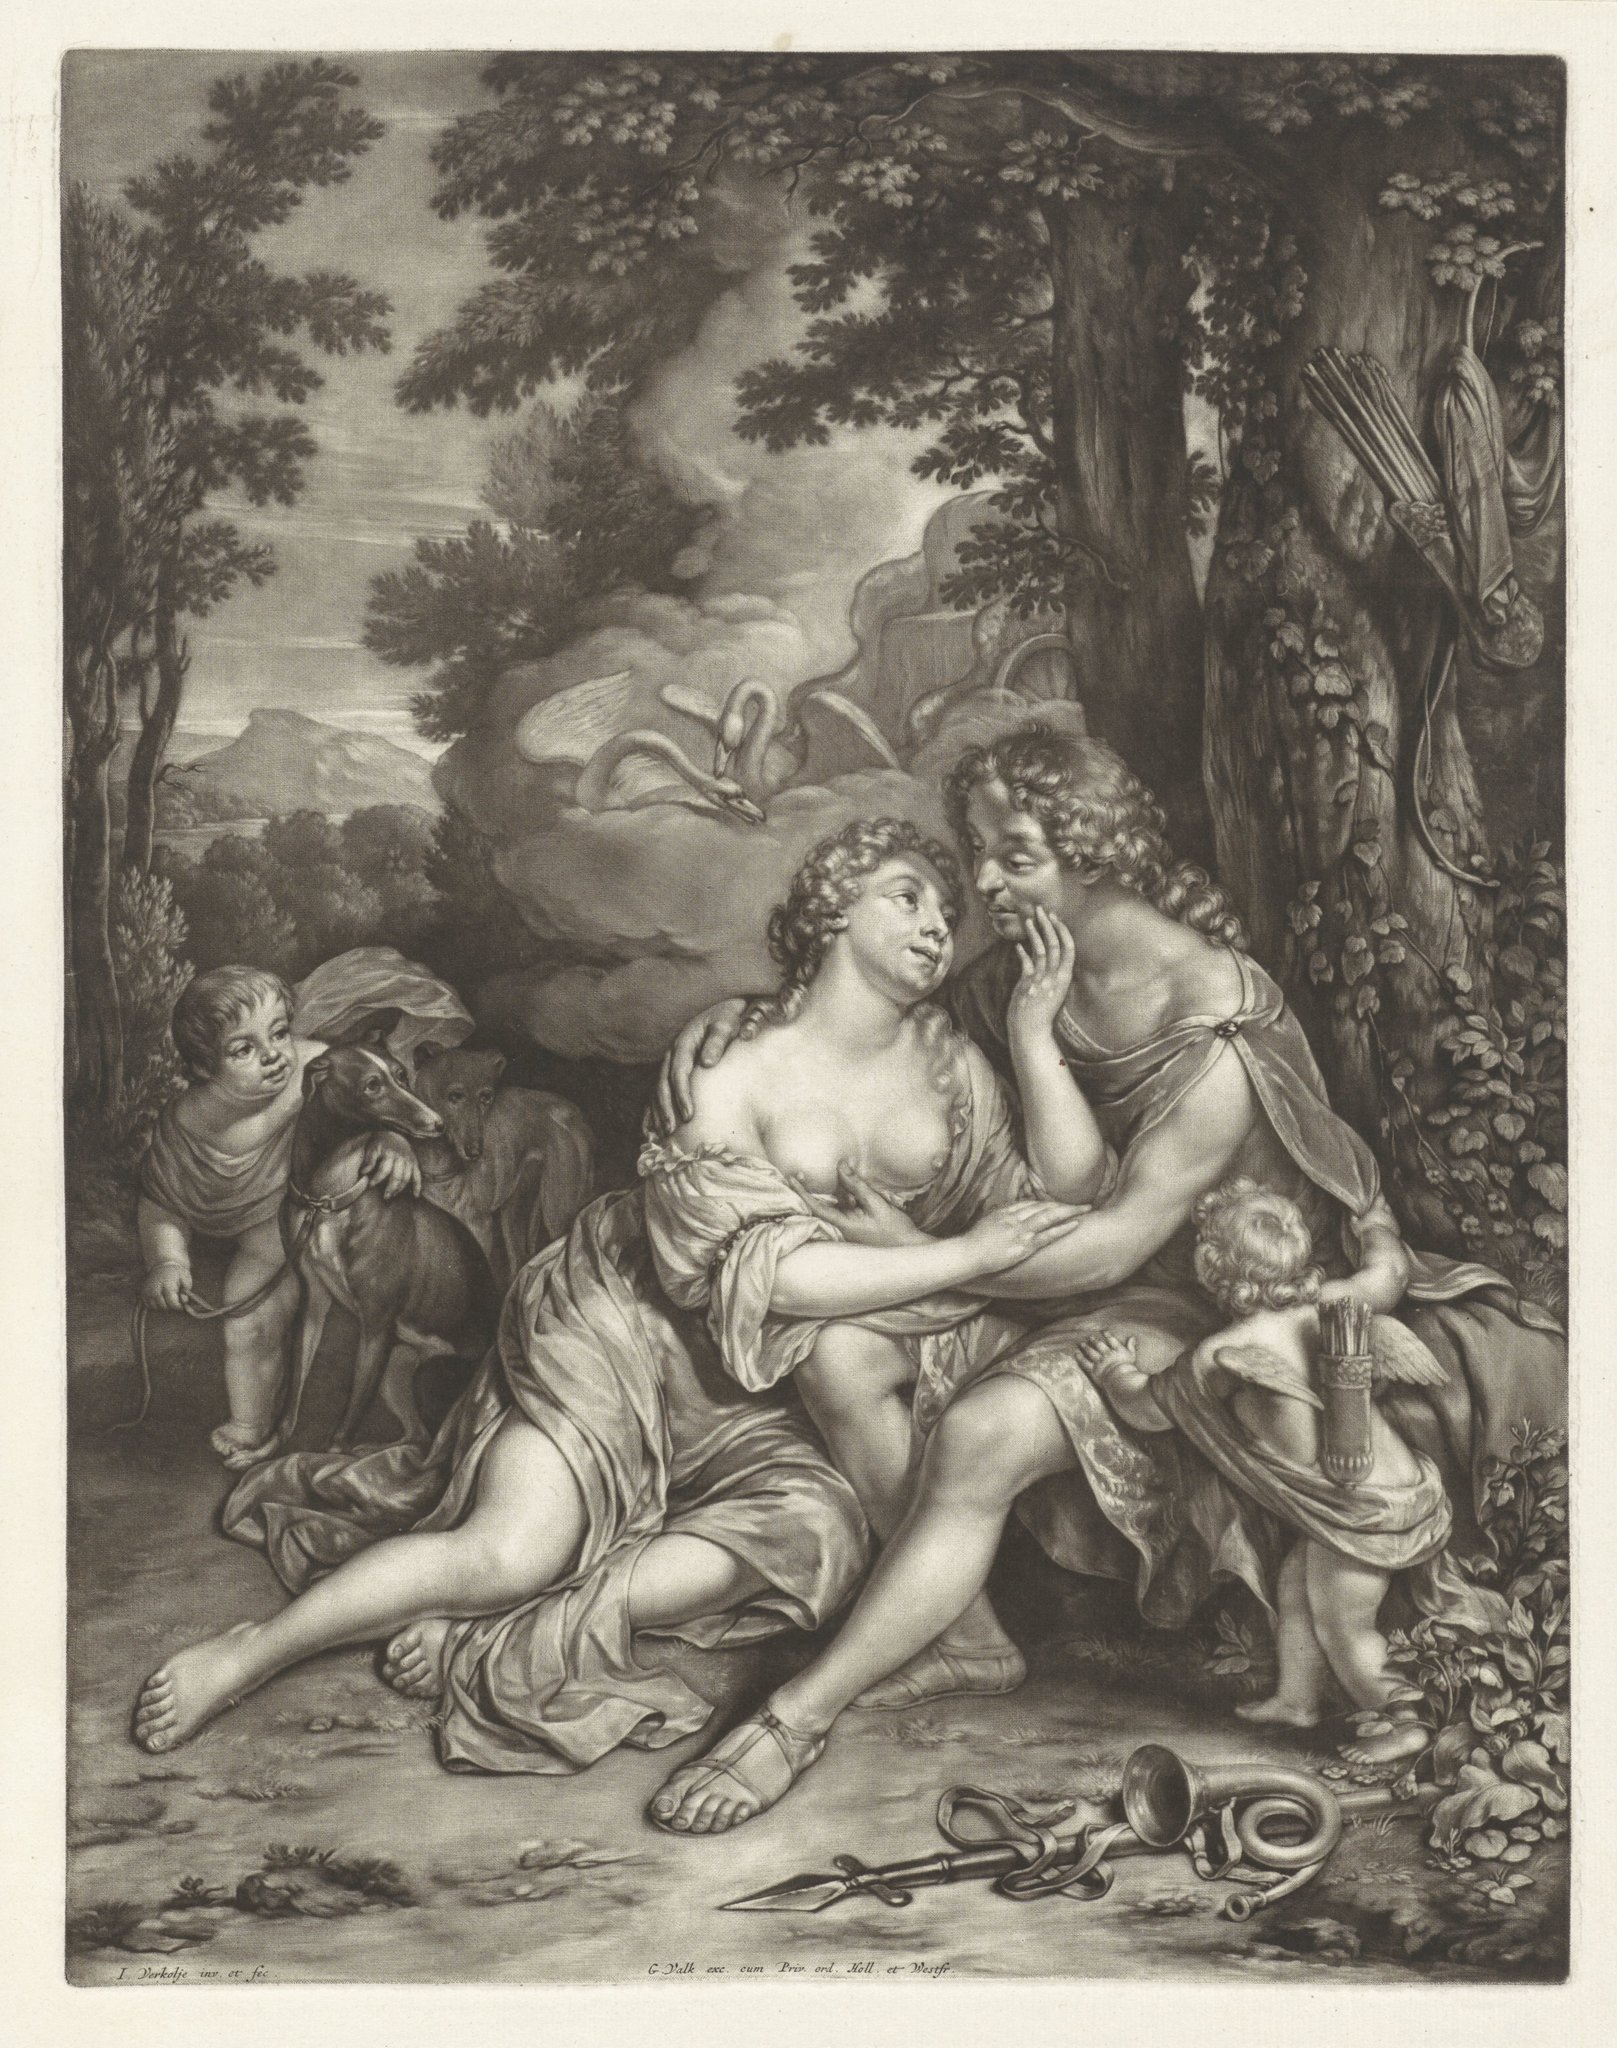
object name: print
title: Venus weerhoudt Adonis van de jacht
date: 1666-1726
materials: paper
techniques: mezzotint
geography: delft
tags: venus and adonis as lovers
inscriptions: collector's mark: Lugt 240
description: Venus en Amor proberen Adonis te beletten om op jacht te gaan. Adonis gaat echter toch jagen; zijn twee jachthonden staan al klaar. Op de voorgrond een speer en een jachthoorn.